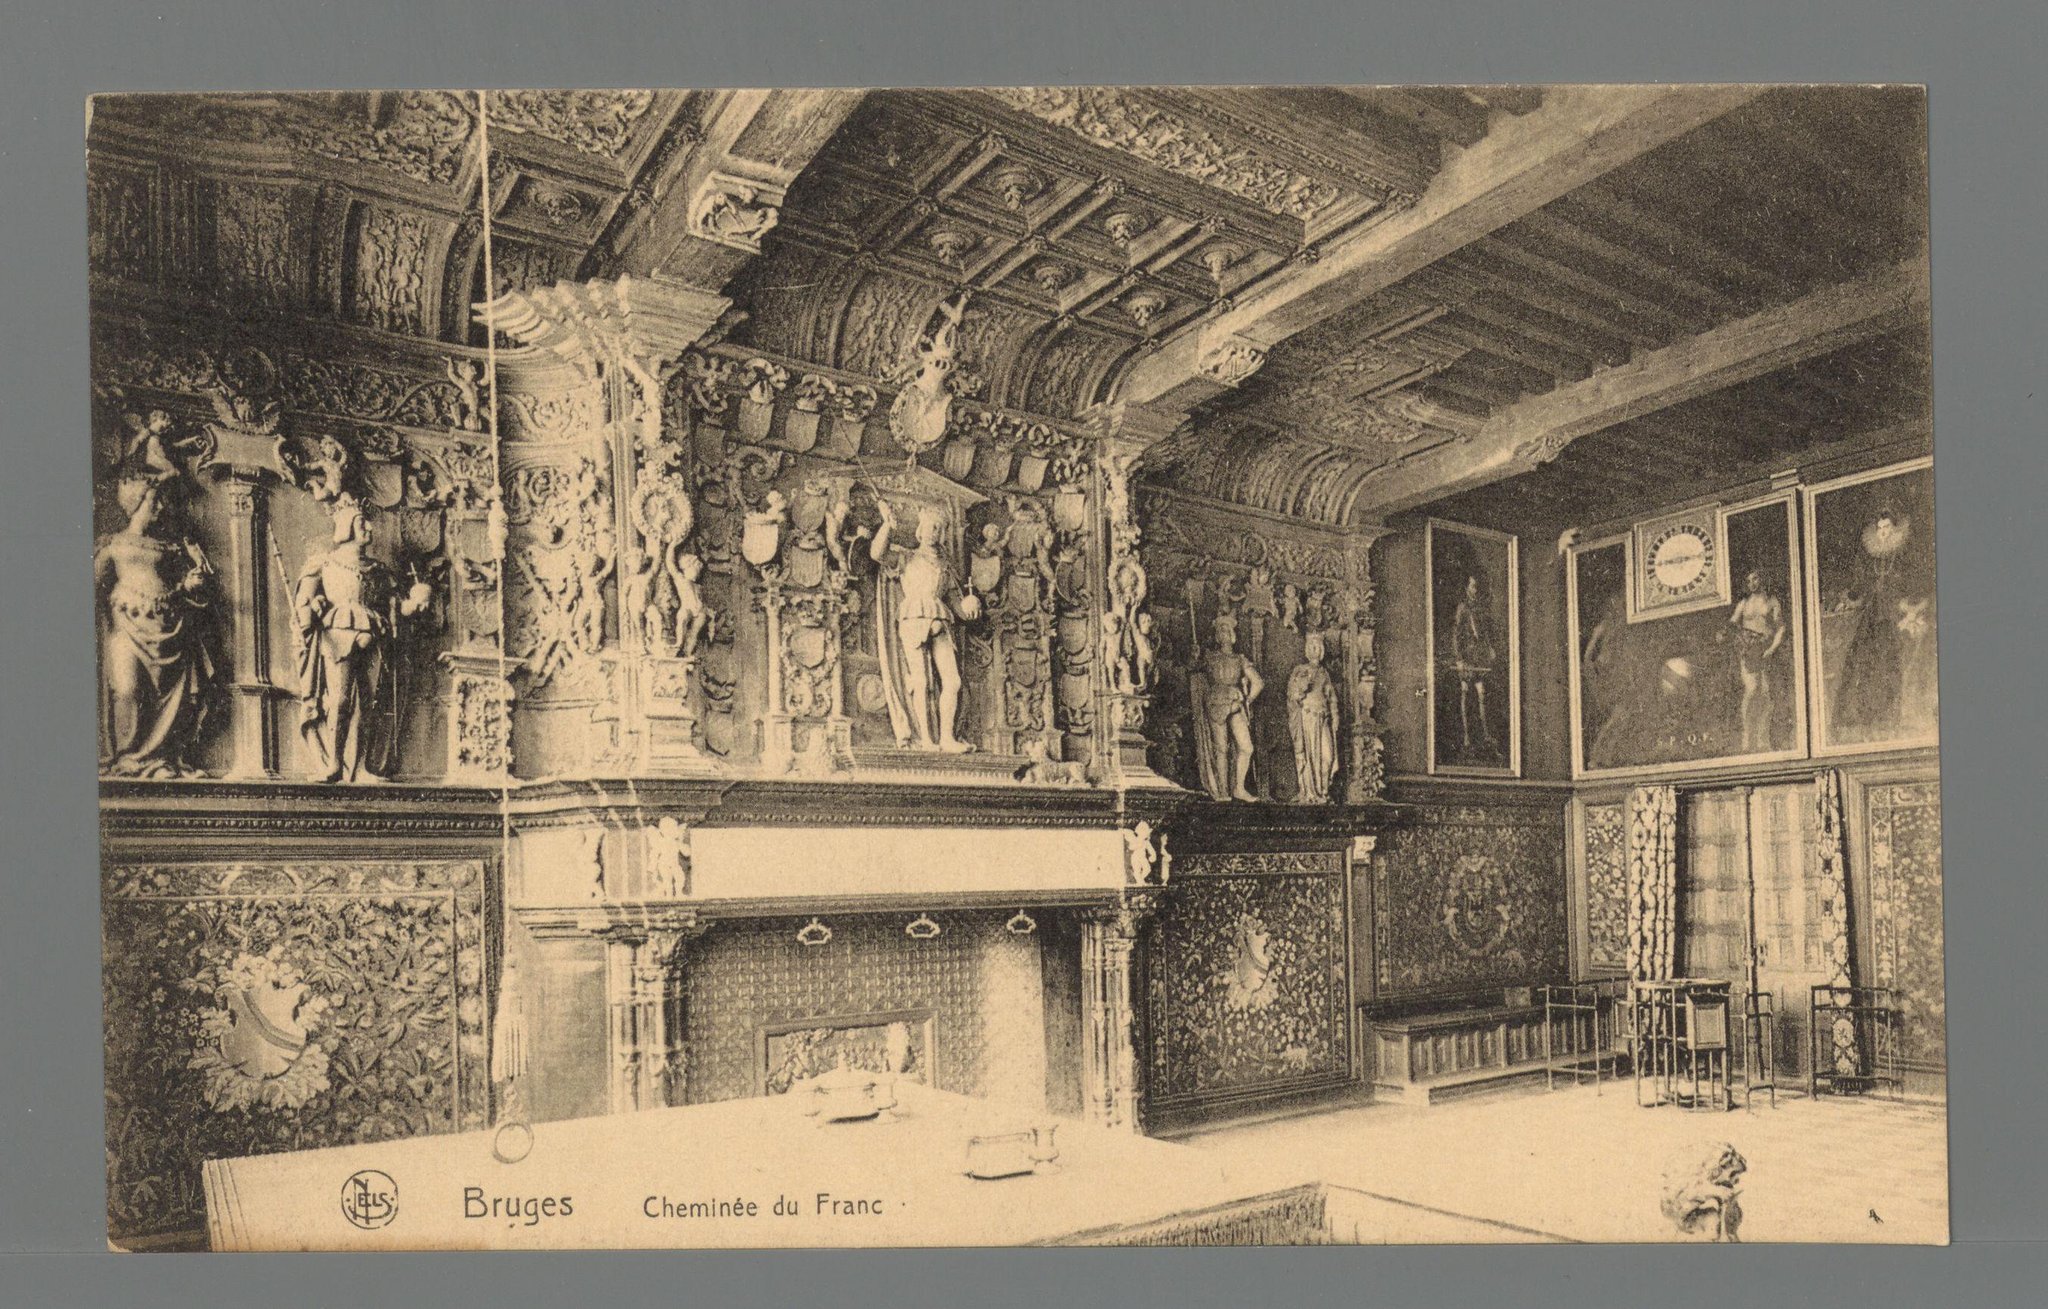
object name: photomechanical print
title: Bruges. Cheminée du Franc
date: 1913-1930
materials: cardboard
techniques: photograph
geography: brussels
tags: chimney, interior ~ representation of a building